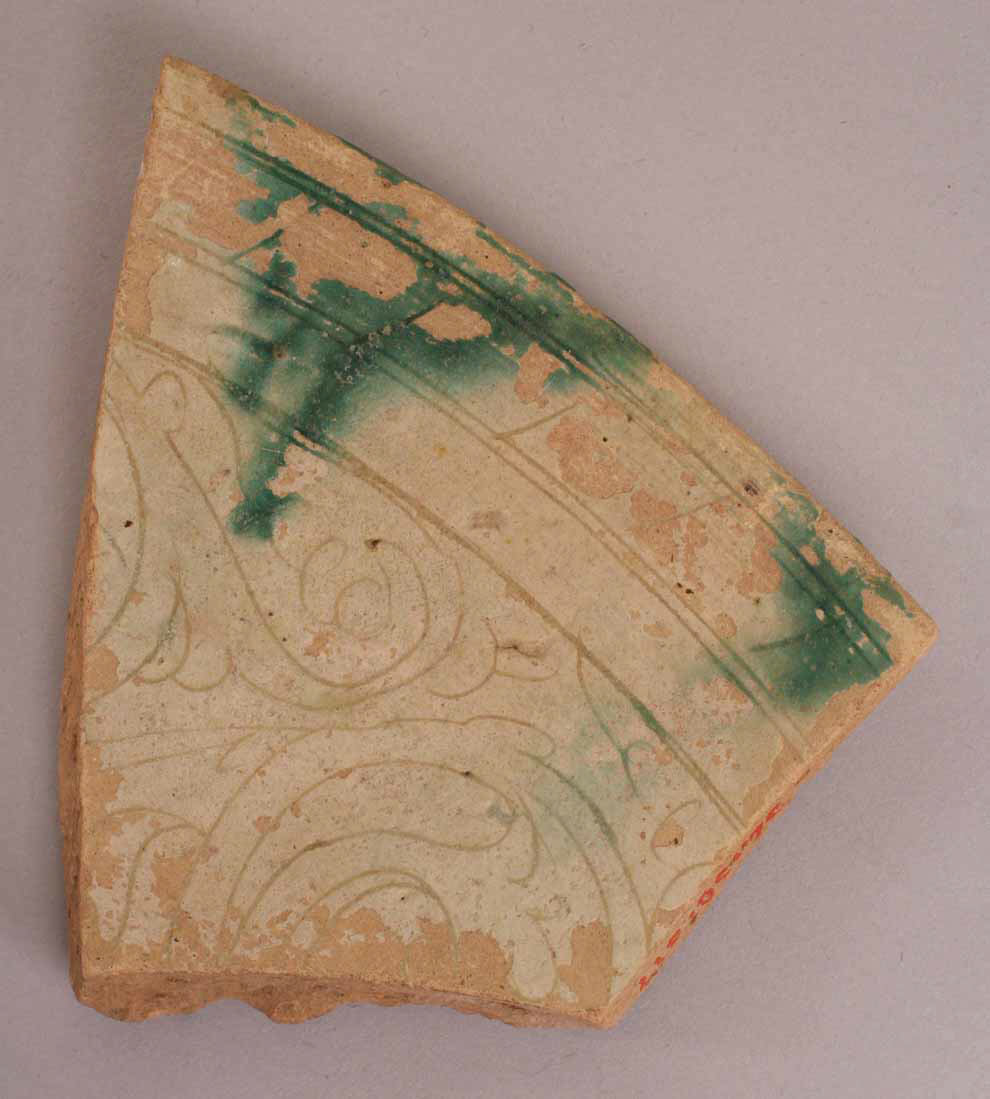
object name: fragment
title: Ceramic Fragment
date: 701-900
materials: earthenware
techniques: glazing, incising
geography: iraq